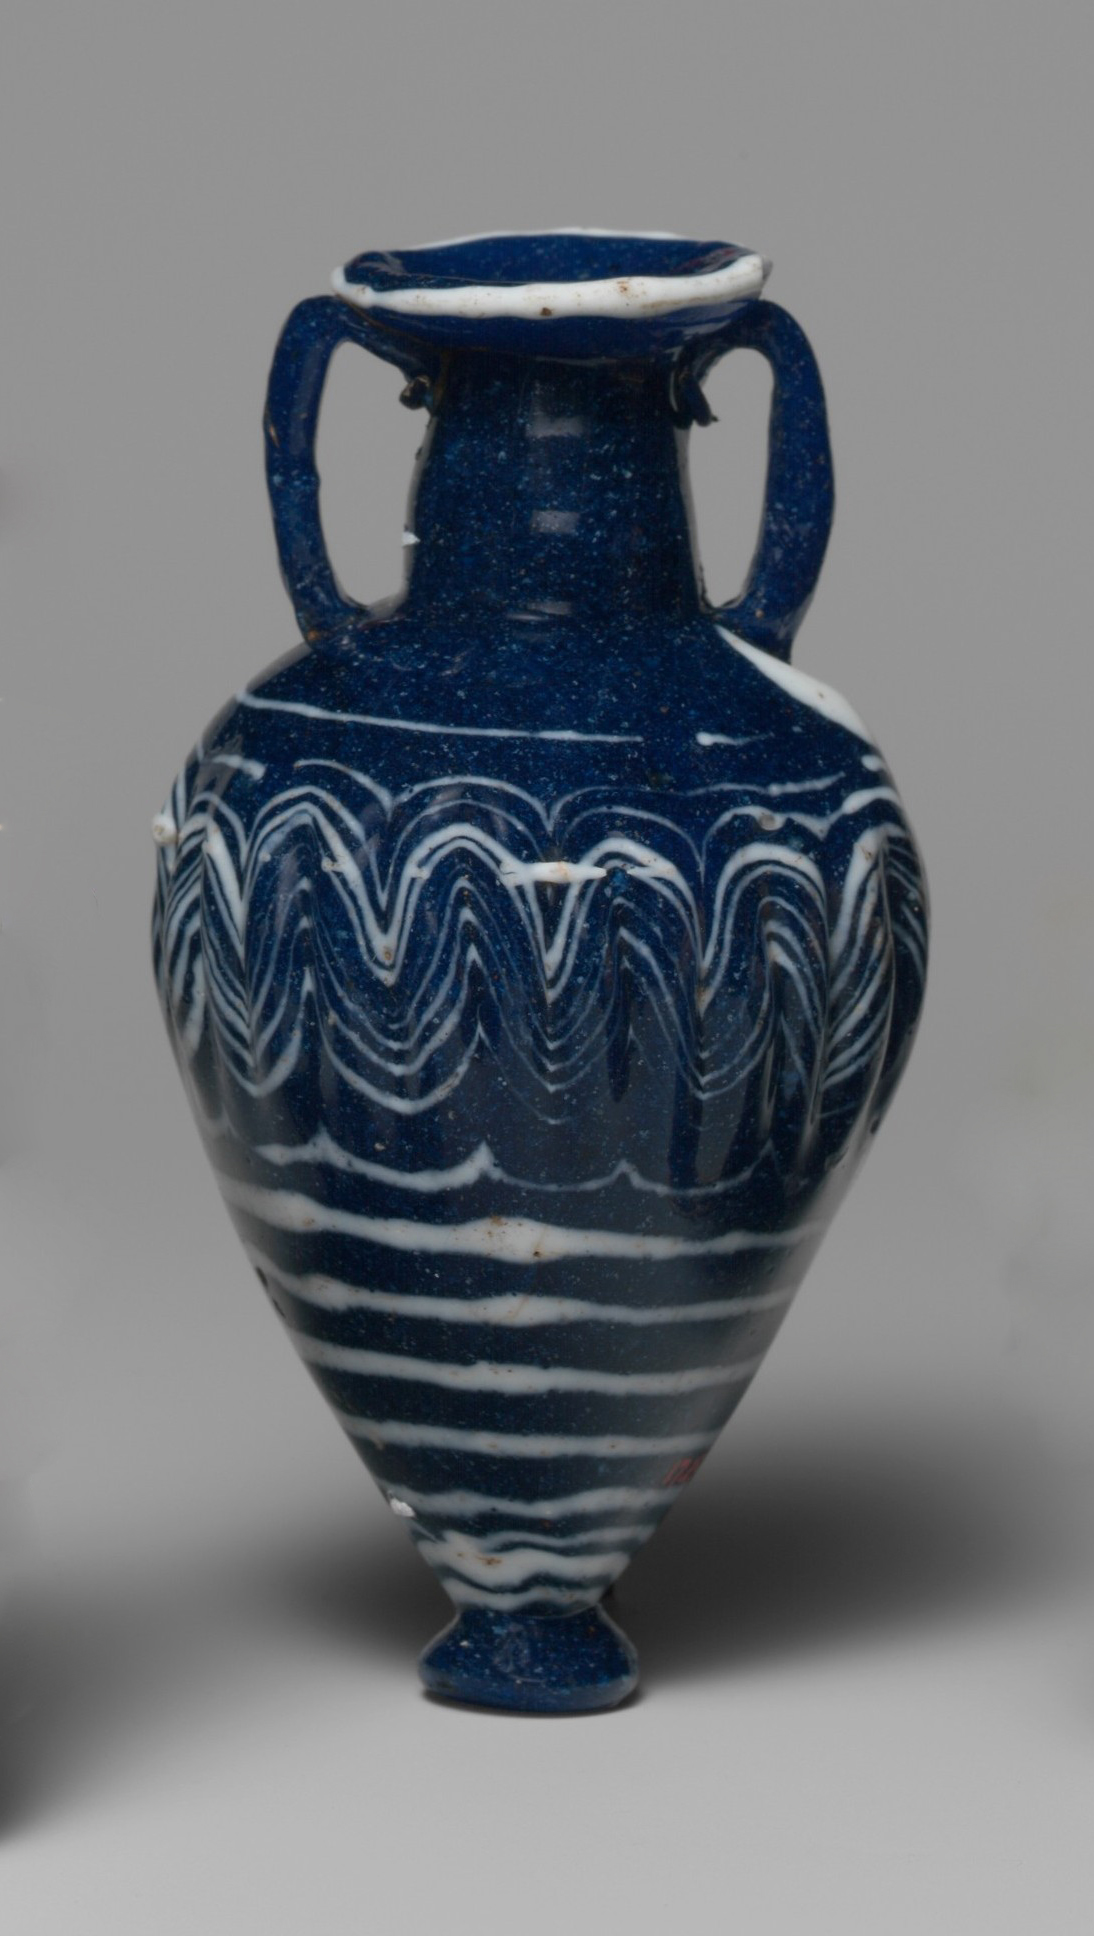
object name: amphoriskos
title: Glass amphoriskos (perfume bottle)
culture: greek, eastern mediterranean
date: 534-401 BCE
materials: glass